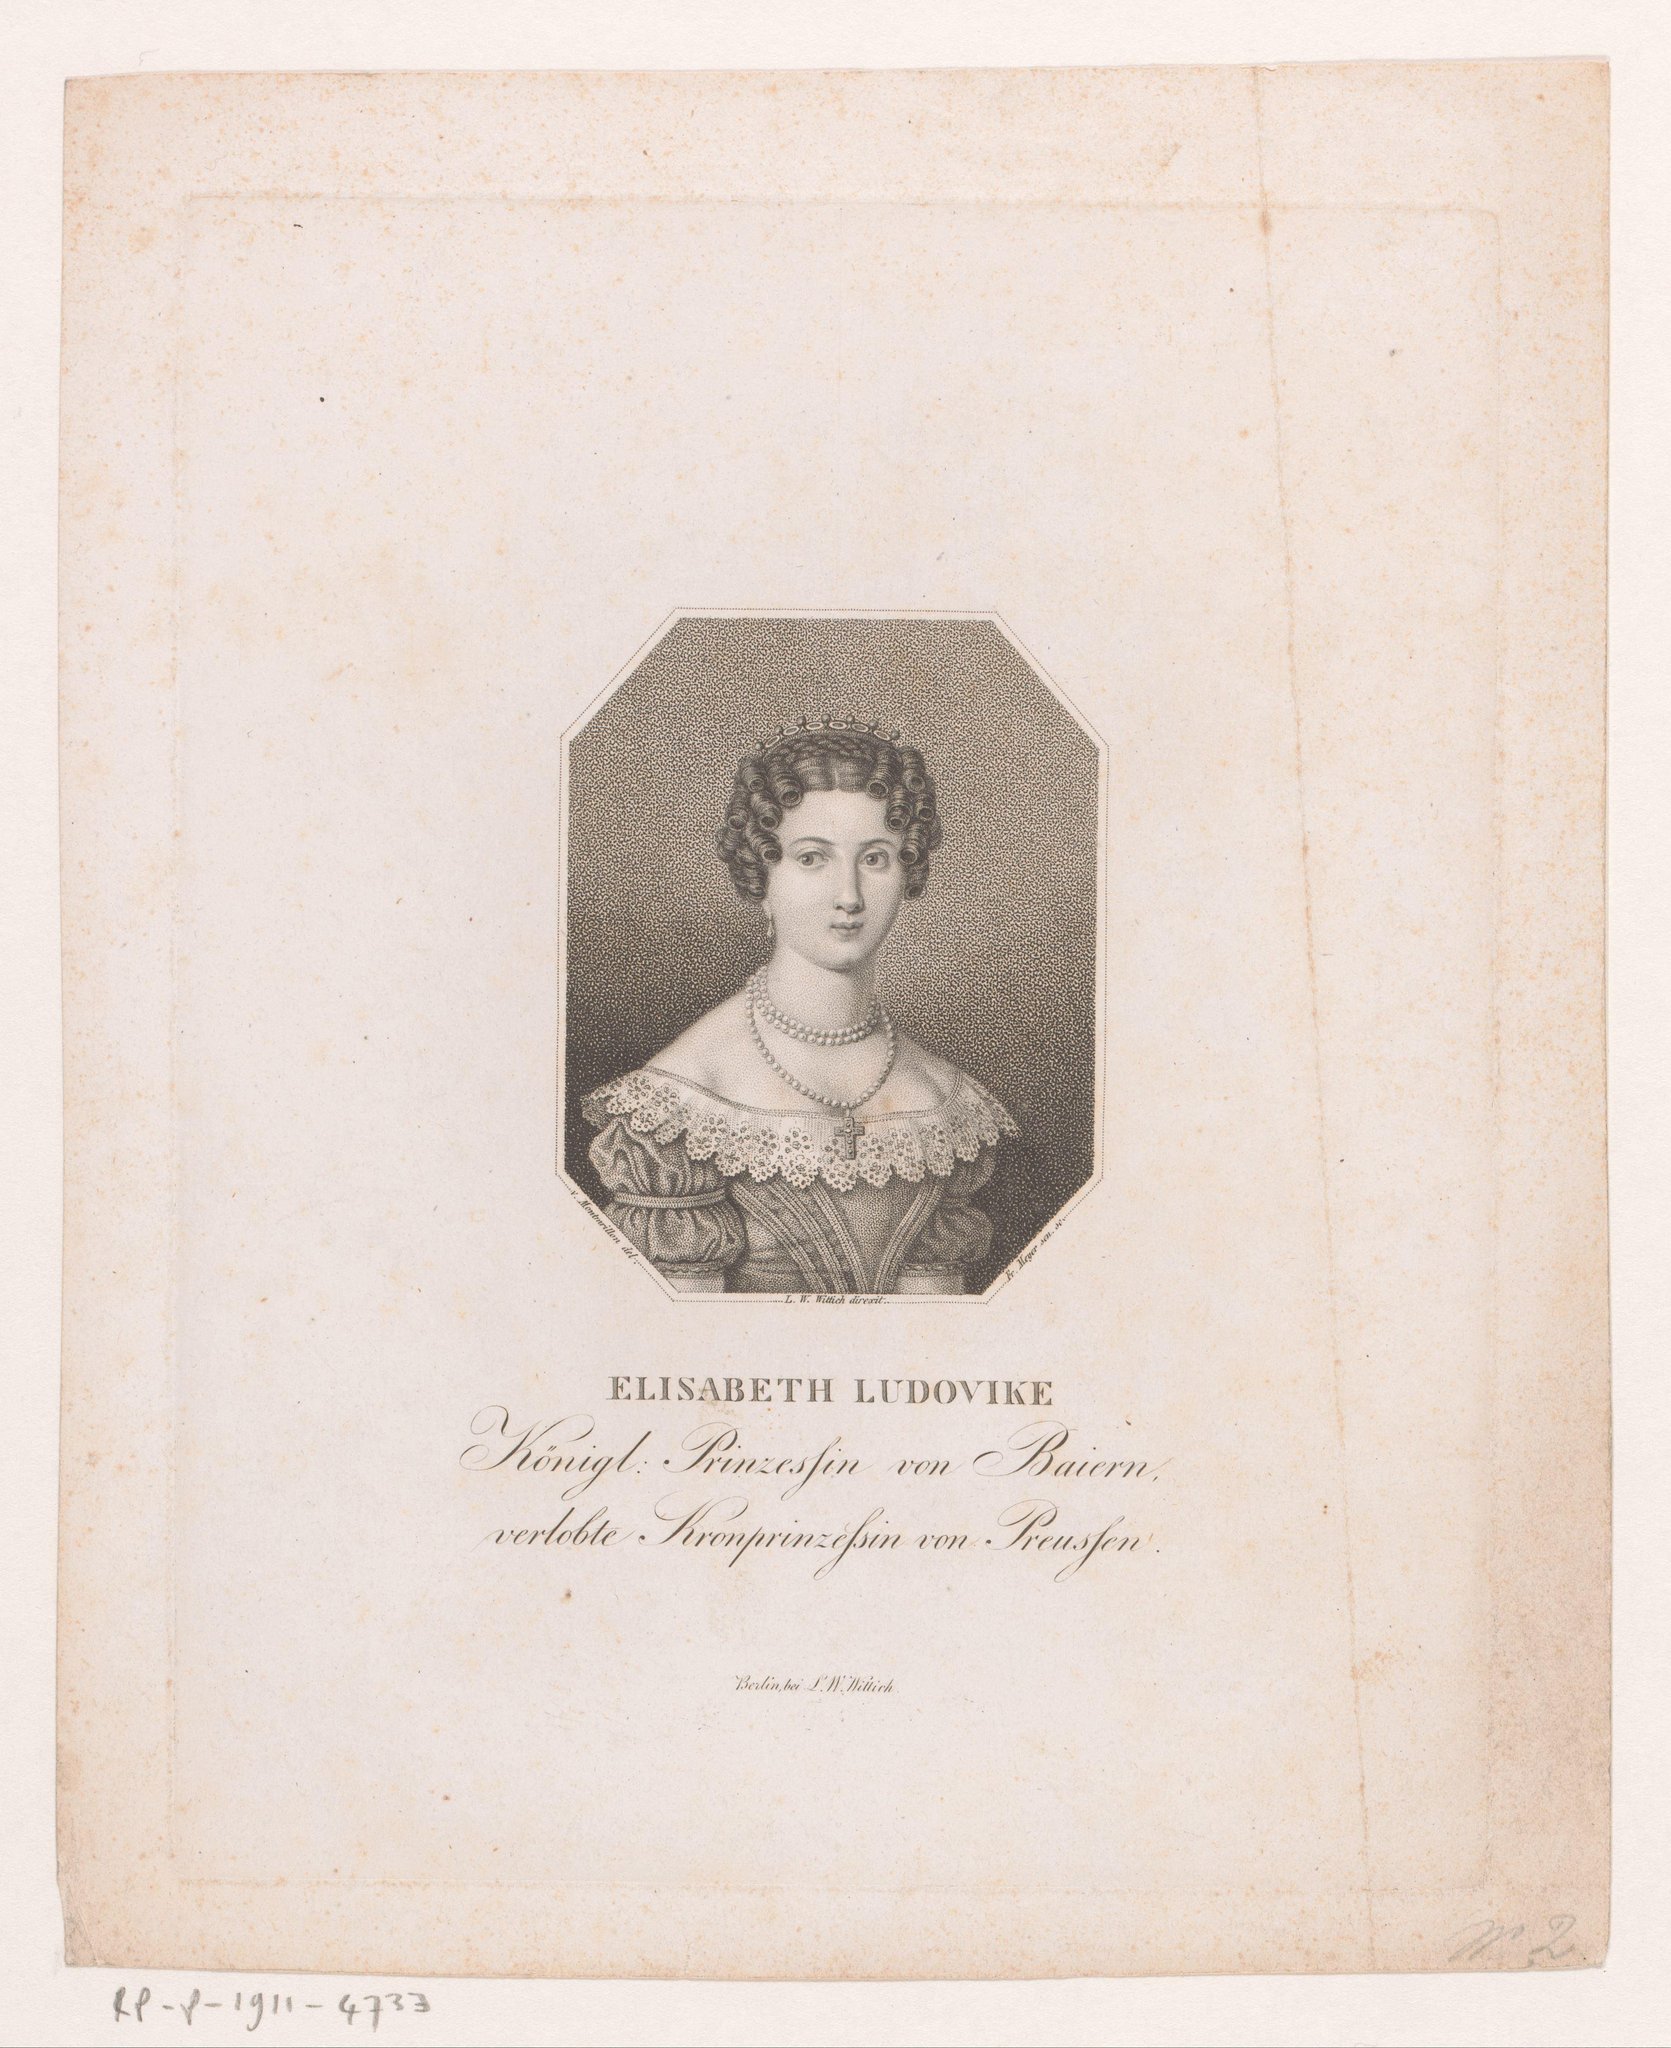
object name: print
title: Portret van Elisabeth Ludovika van Beieren, koningin van Pruisen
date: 1816-1880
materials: paper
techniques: engraving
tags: historical persons - bb - woman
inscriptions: collector's mark: Lugt 2228